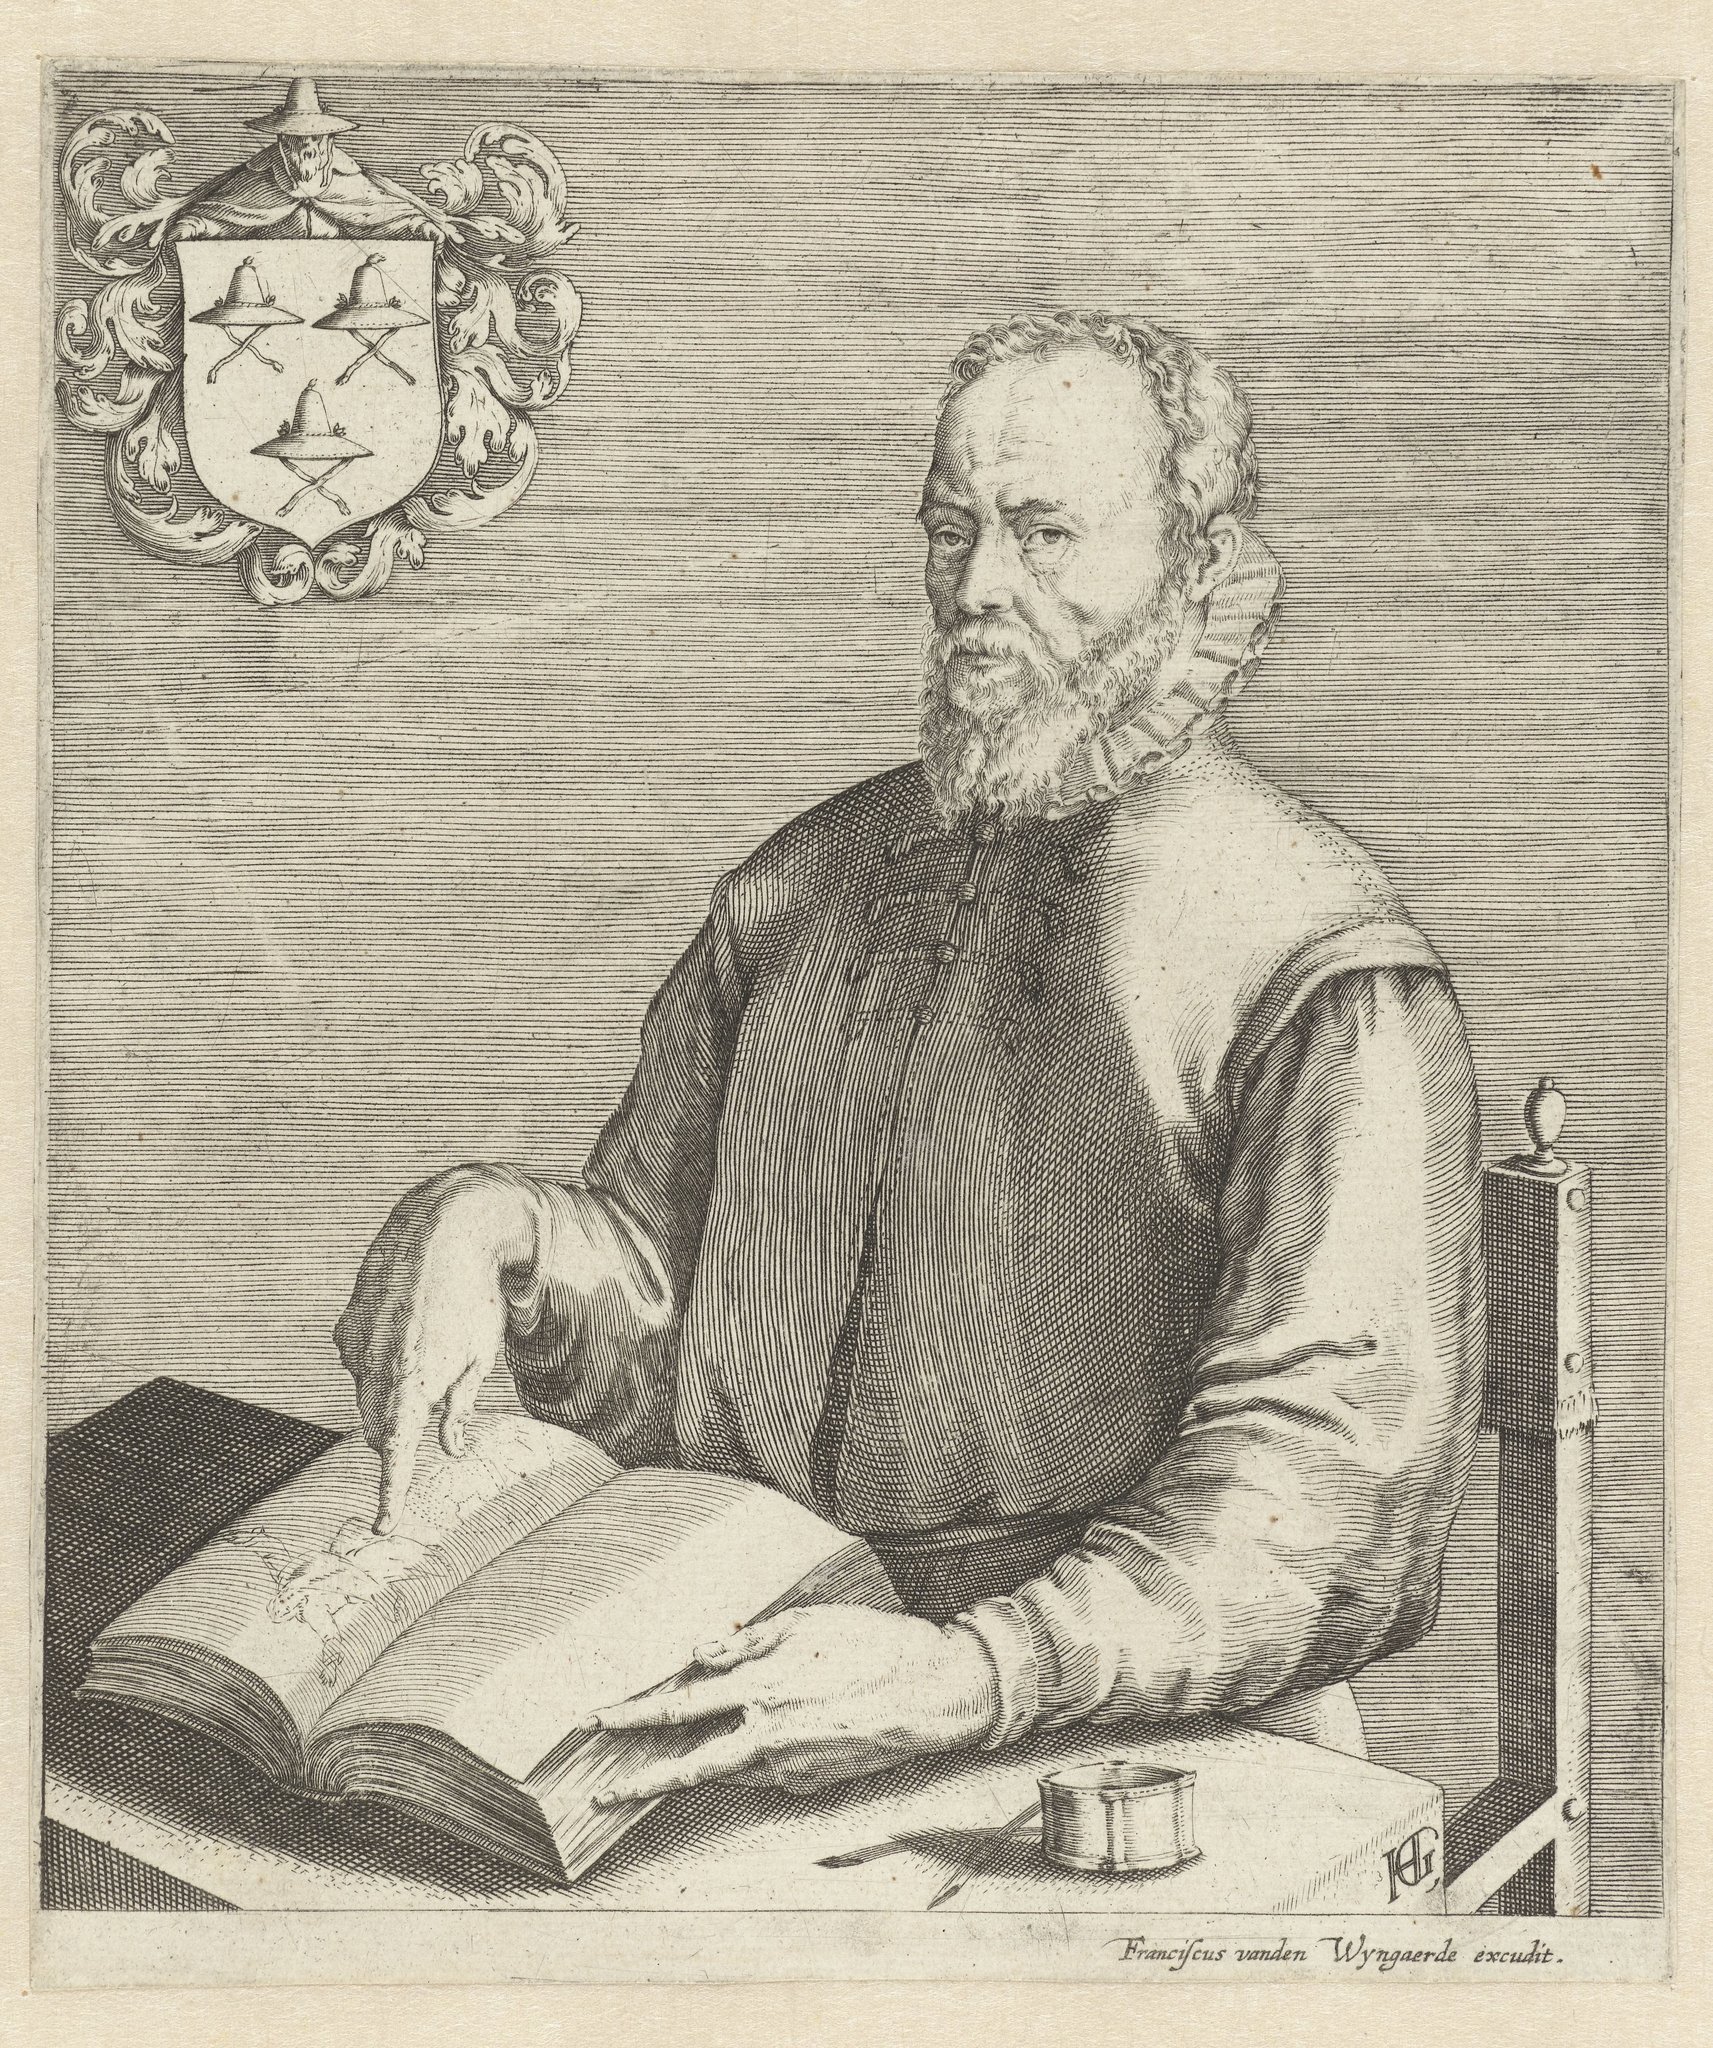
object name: print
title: Portret van Gerard de Jode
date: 1624-1679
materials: paper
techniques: engraving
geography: low countries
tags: nijmegen, antwerp, draughtsman, gerard de jode, historical persons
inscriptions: collector's mark: Lugt 240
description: Portret van een man, ten halven lijve, zitten aan een tafel, wijzend in een boek. Linksboven een wapen.